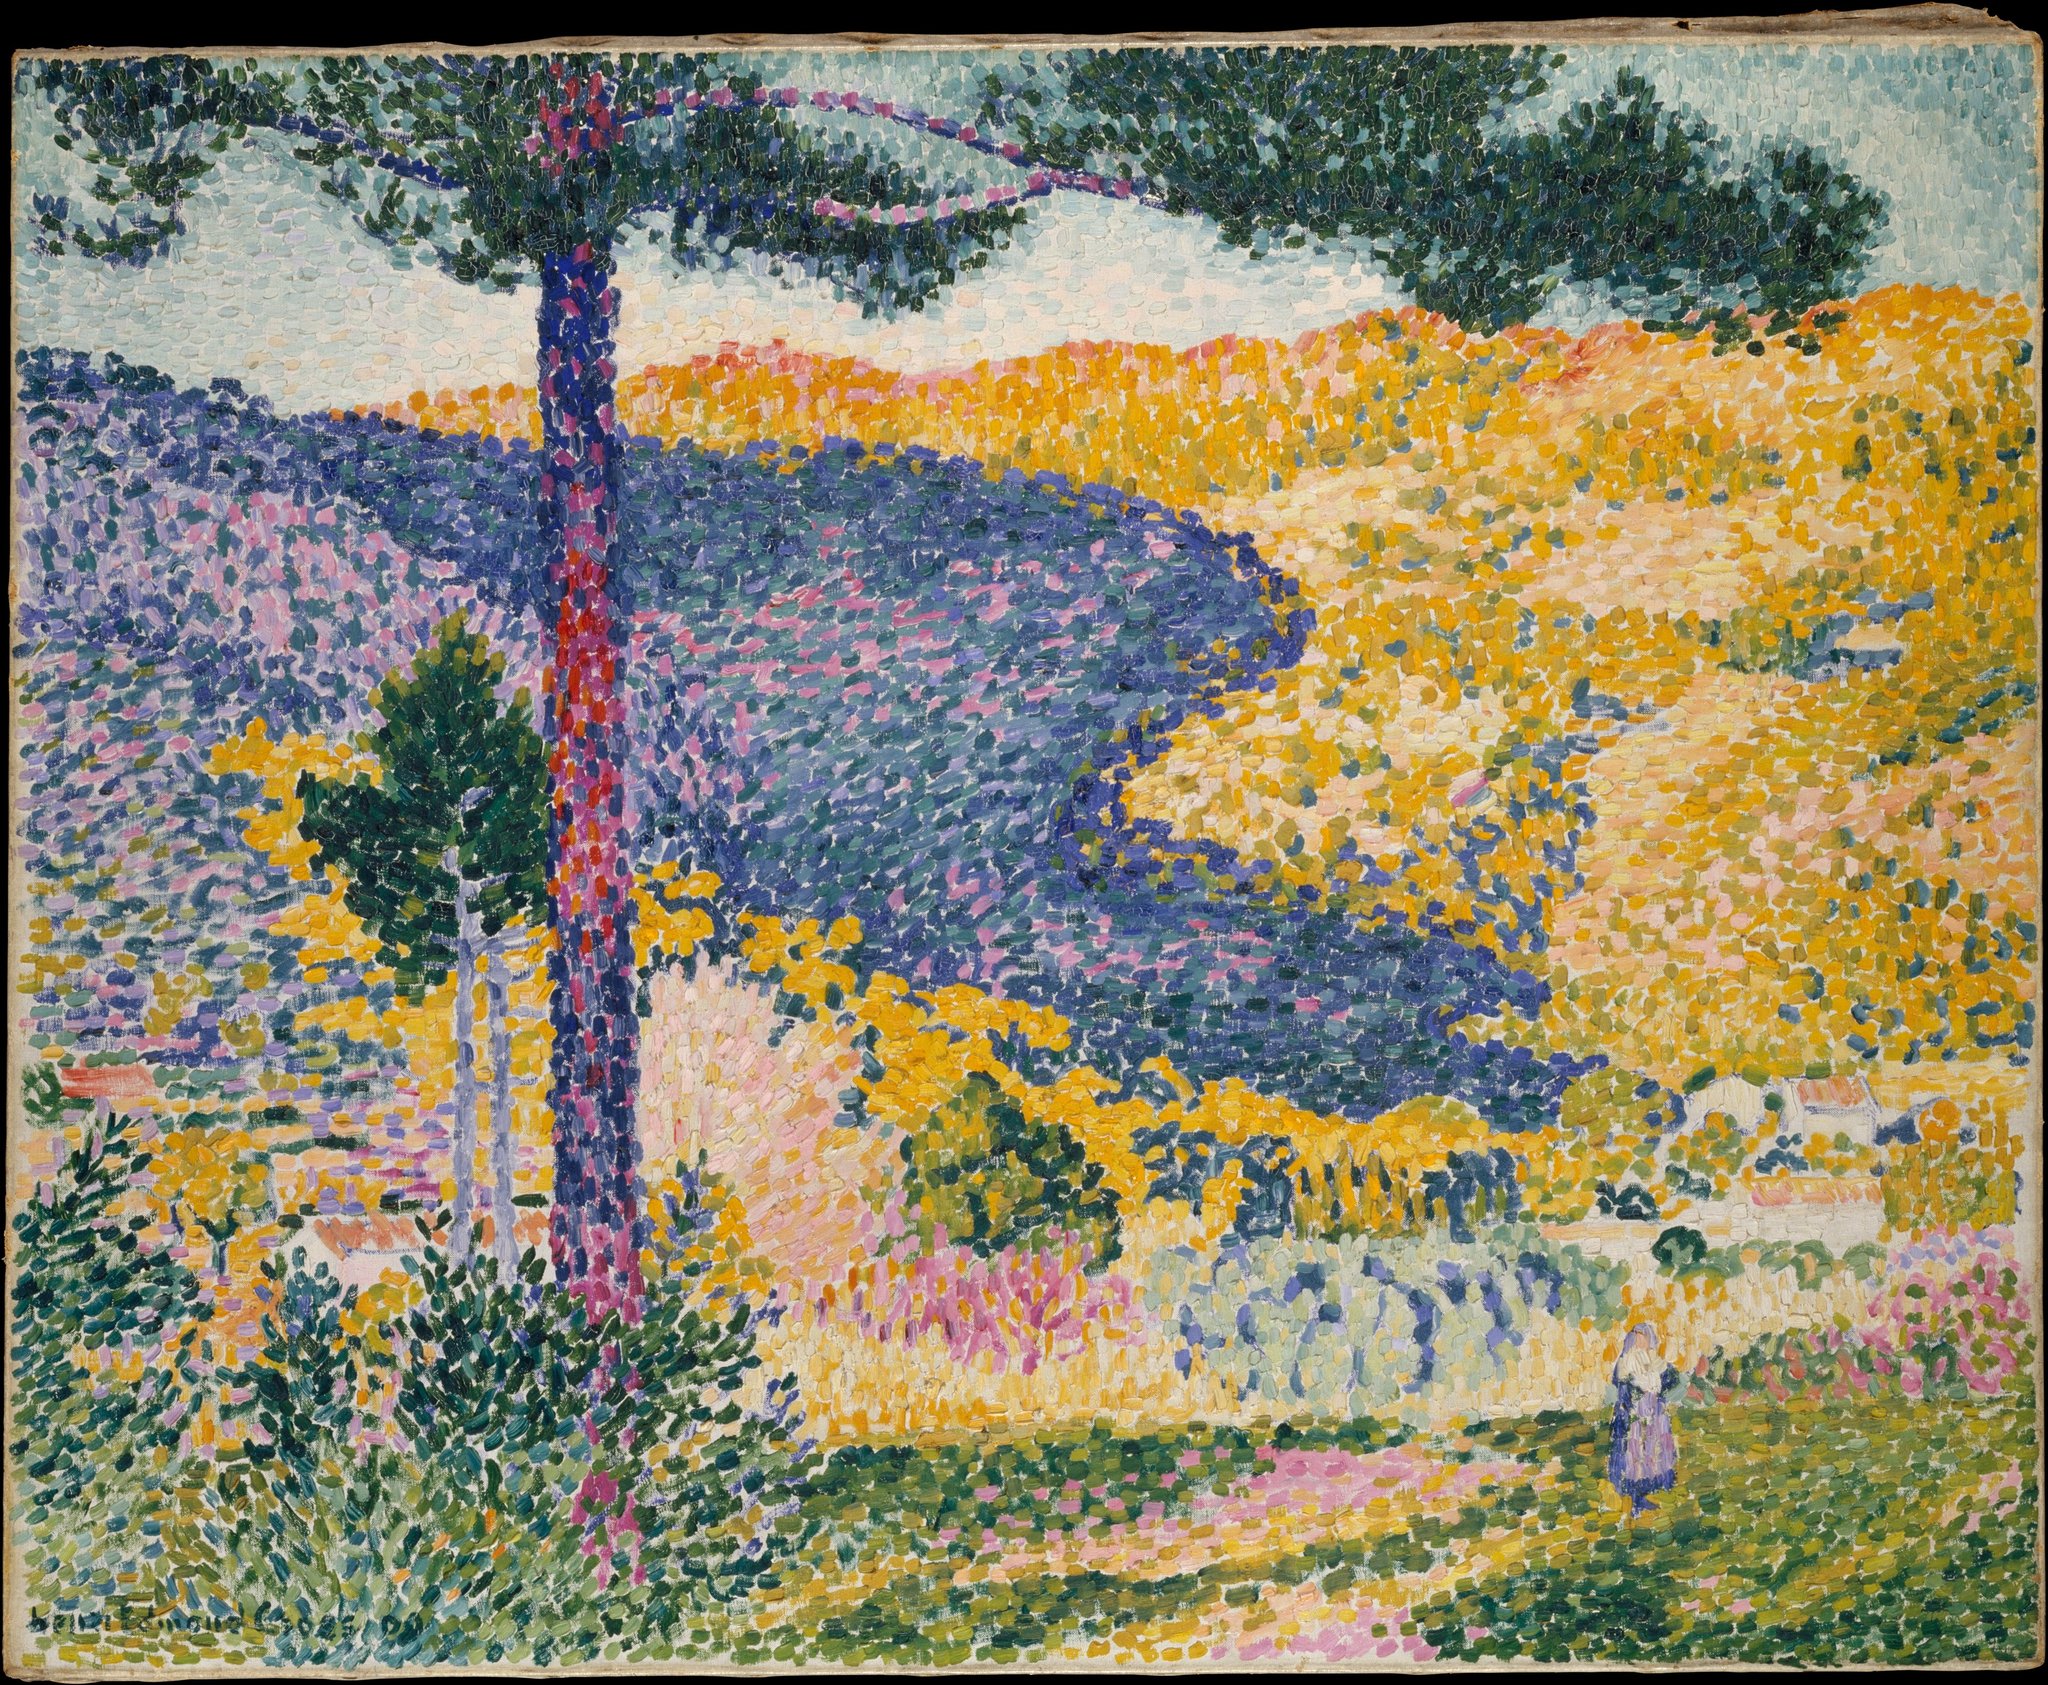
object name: painting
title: Valley with Fir (Shade on the Mountain)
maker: henri-edmond cross (henri-edmond delacroix)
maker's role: artist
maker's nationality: french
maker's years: 1856-1910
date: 1909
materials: canvas, oil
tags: landscapes